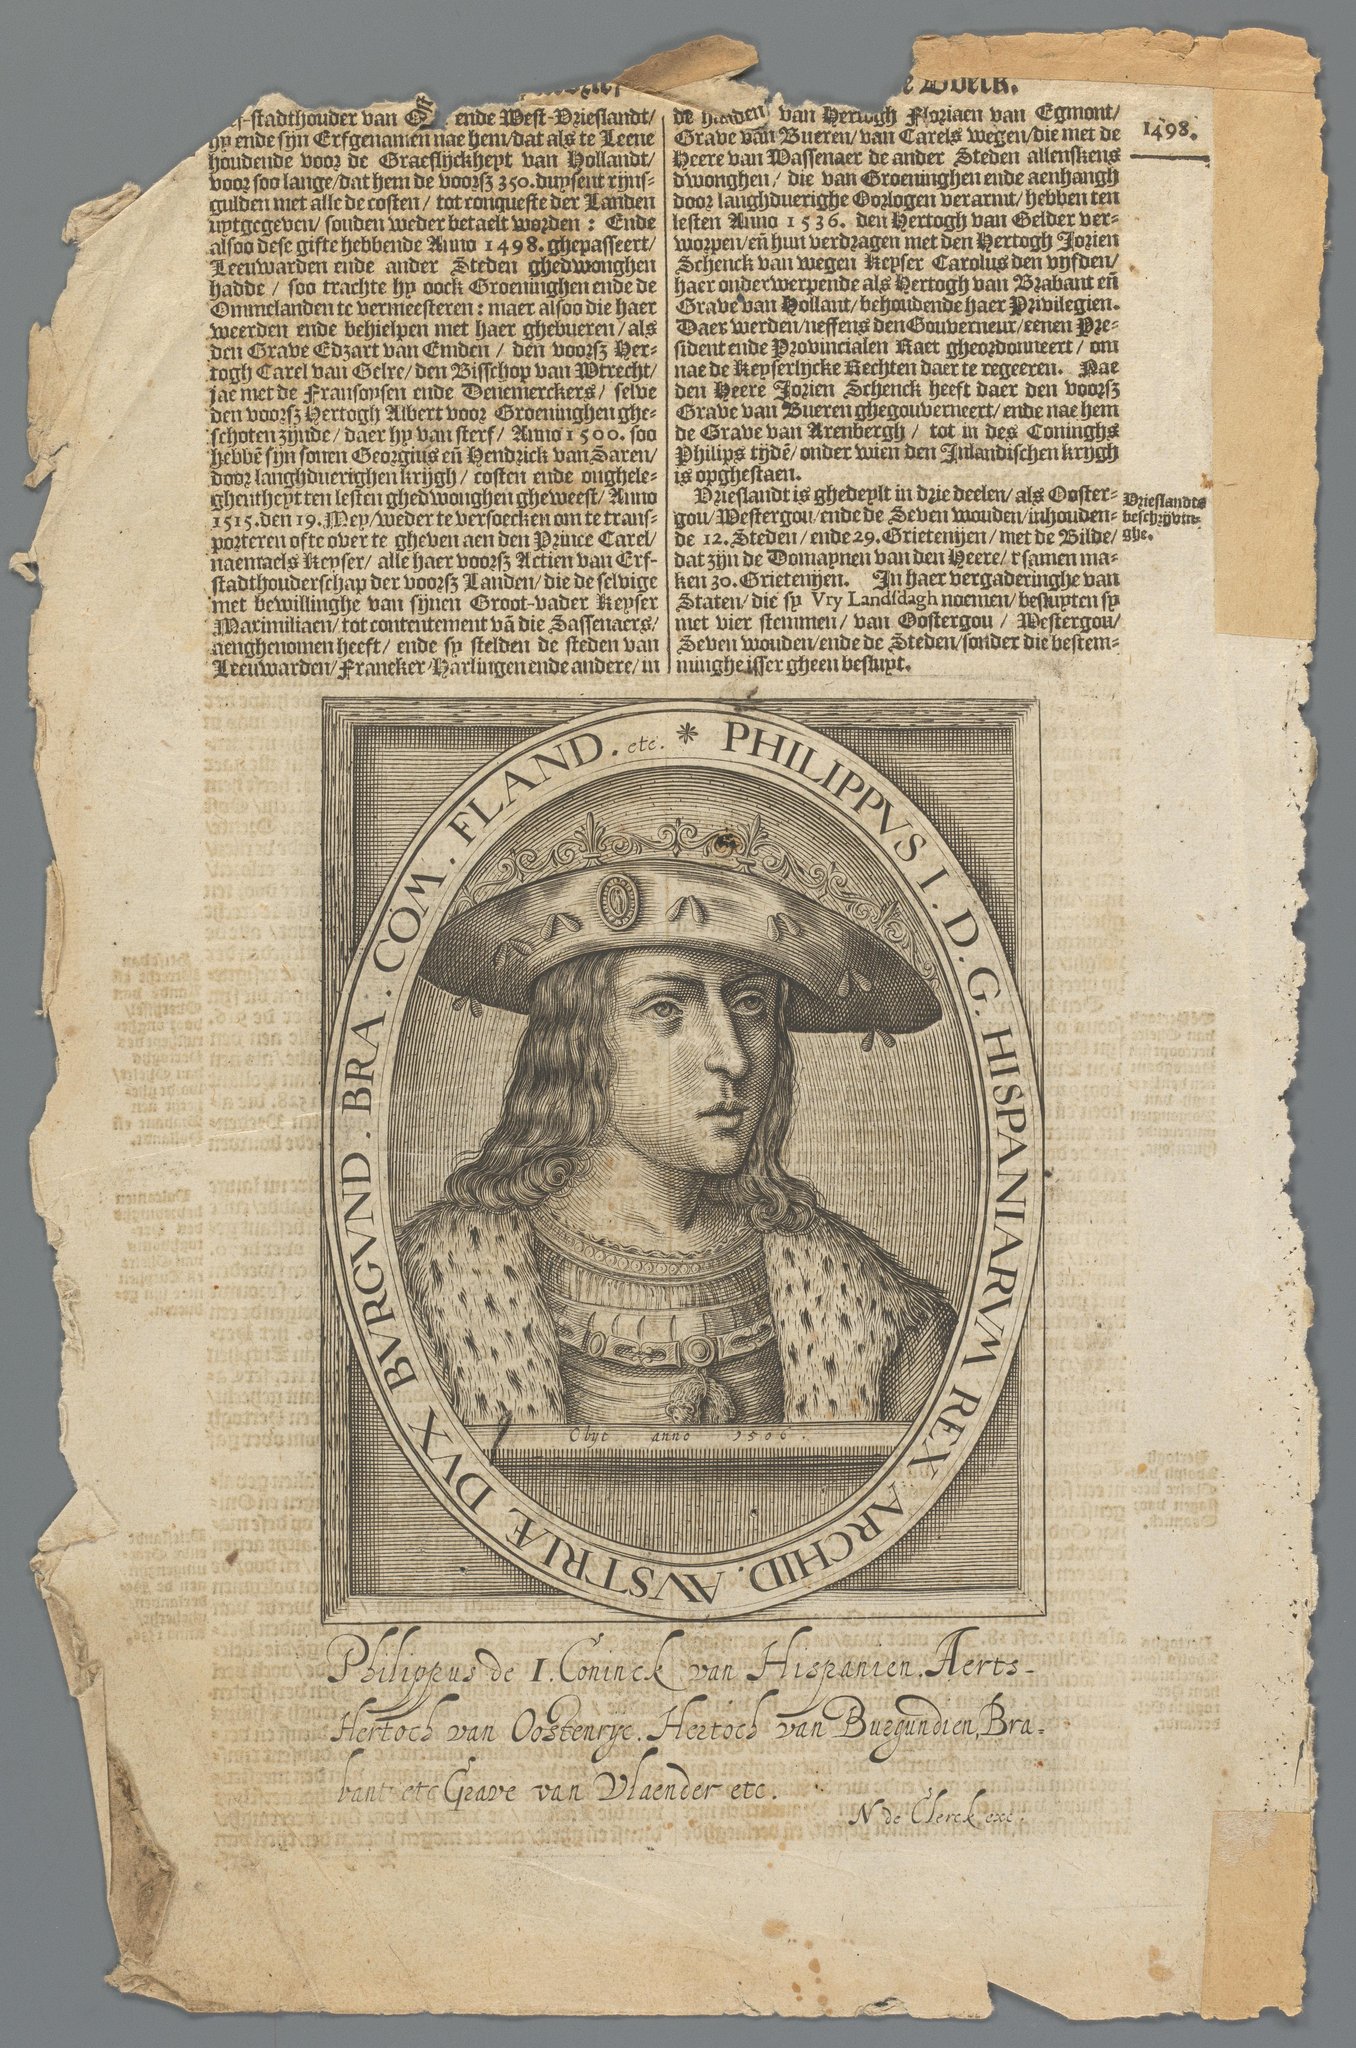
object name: book illustration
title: Philippus i.d.g. Hispaniarum rex archid. Austriae dux Burgund. bra. com. Fland.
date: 1614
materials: paper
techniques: engraving, letterpress printing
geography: the hague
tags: filips de schone (hertog van bourgondië), historical persons, ruler, sovereign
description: Prent uit: Meteren, Emanuel van. Historie der Nederlandscher ende haerder na-buren oorlogen ende geschiedenissen (...). Den Haag: Hillebrant Iacobsz. van Wouw, 1614. Latere staat van prent gebruikt in: Meteren, Emanuel van. Historie der Nederlandscher ende haerder na-buren oorlogen ende geschiedenissen (...). Den Haag: weduwe en erfgenamen van Hillebrant Iacobsz. van Wouw, 1623. Prent mogelijk ook gebruikt in latere edities.